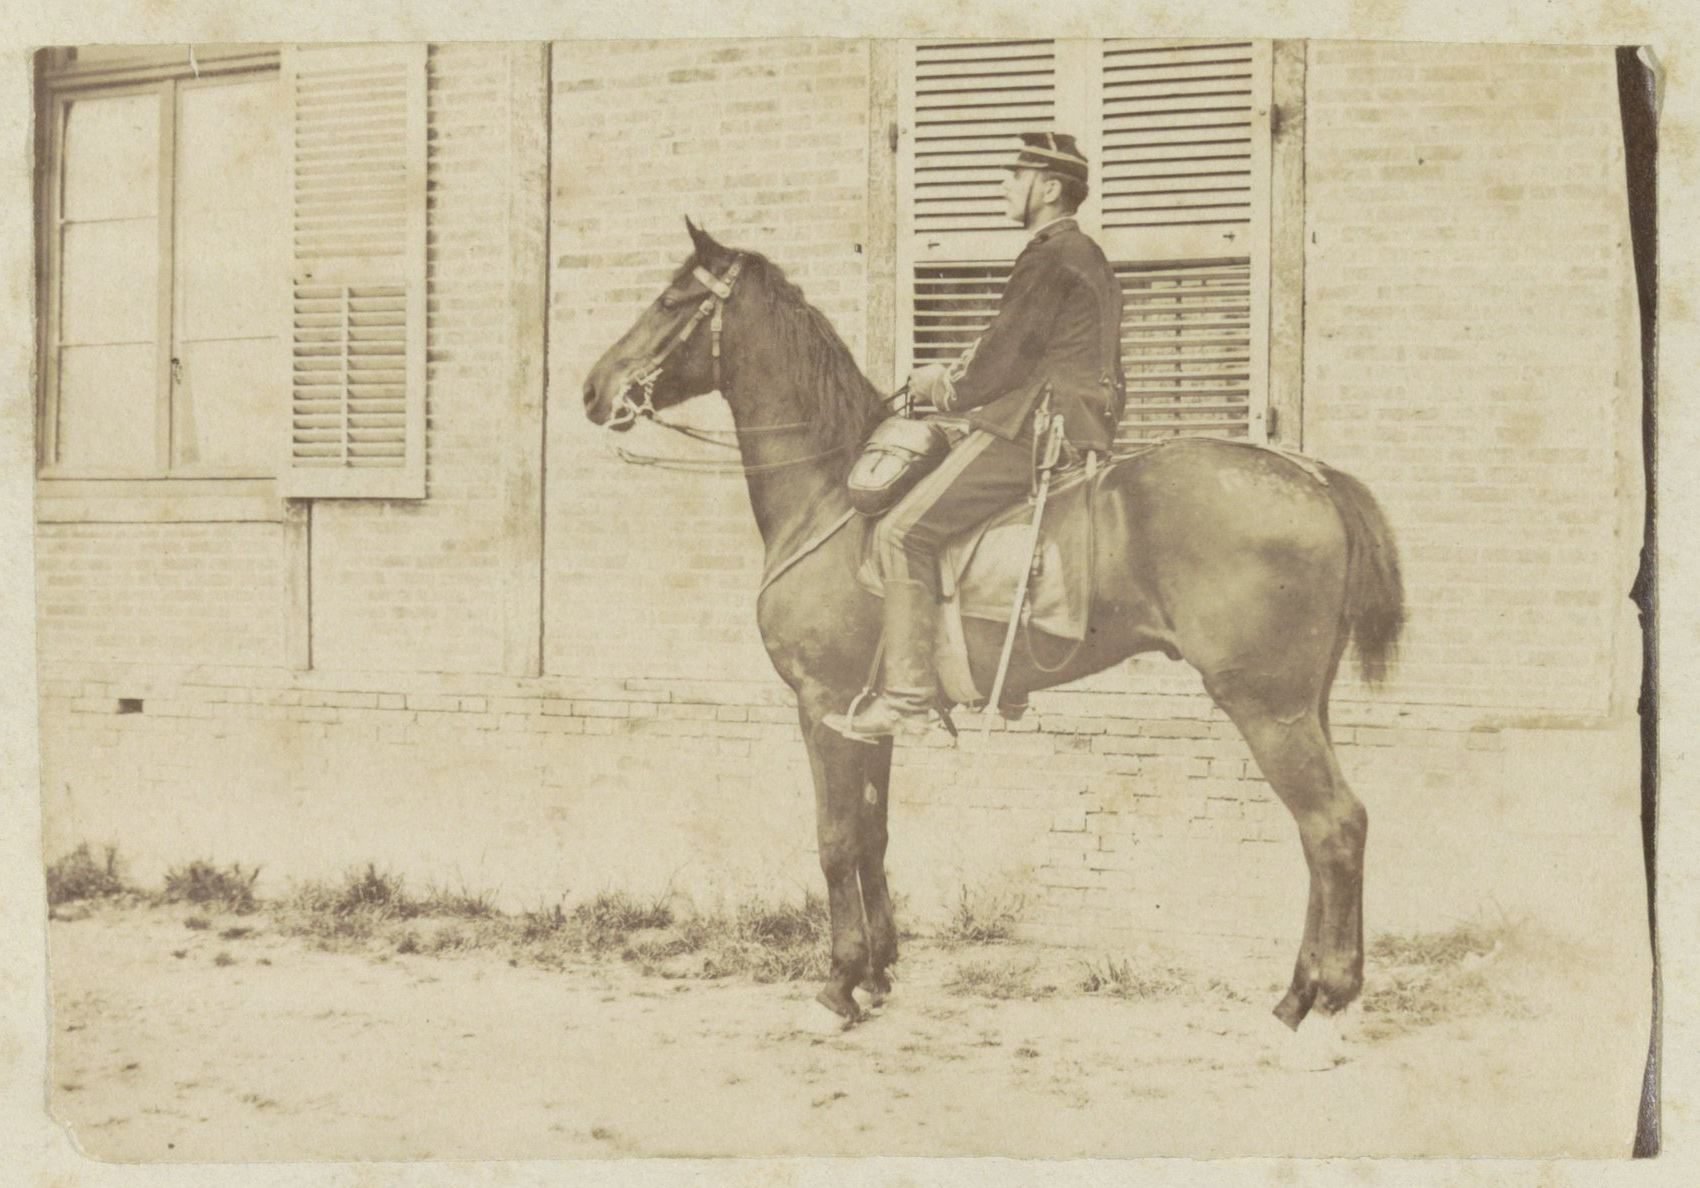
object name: photograph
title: Portret van een Franse militair te paard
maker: Anonymous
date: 1804-1884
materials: photographic support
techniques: albumen print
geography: france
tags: land forces (+ cavalry, horsemen)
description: Onderdeel van Album van een Franse amateurfotograaf met opnames van familie, militairen, industrie, landschappen en bezienswaardigheden in Frankrijk.